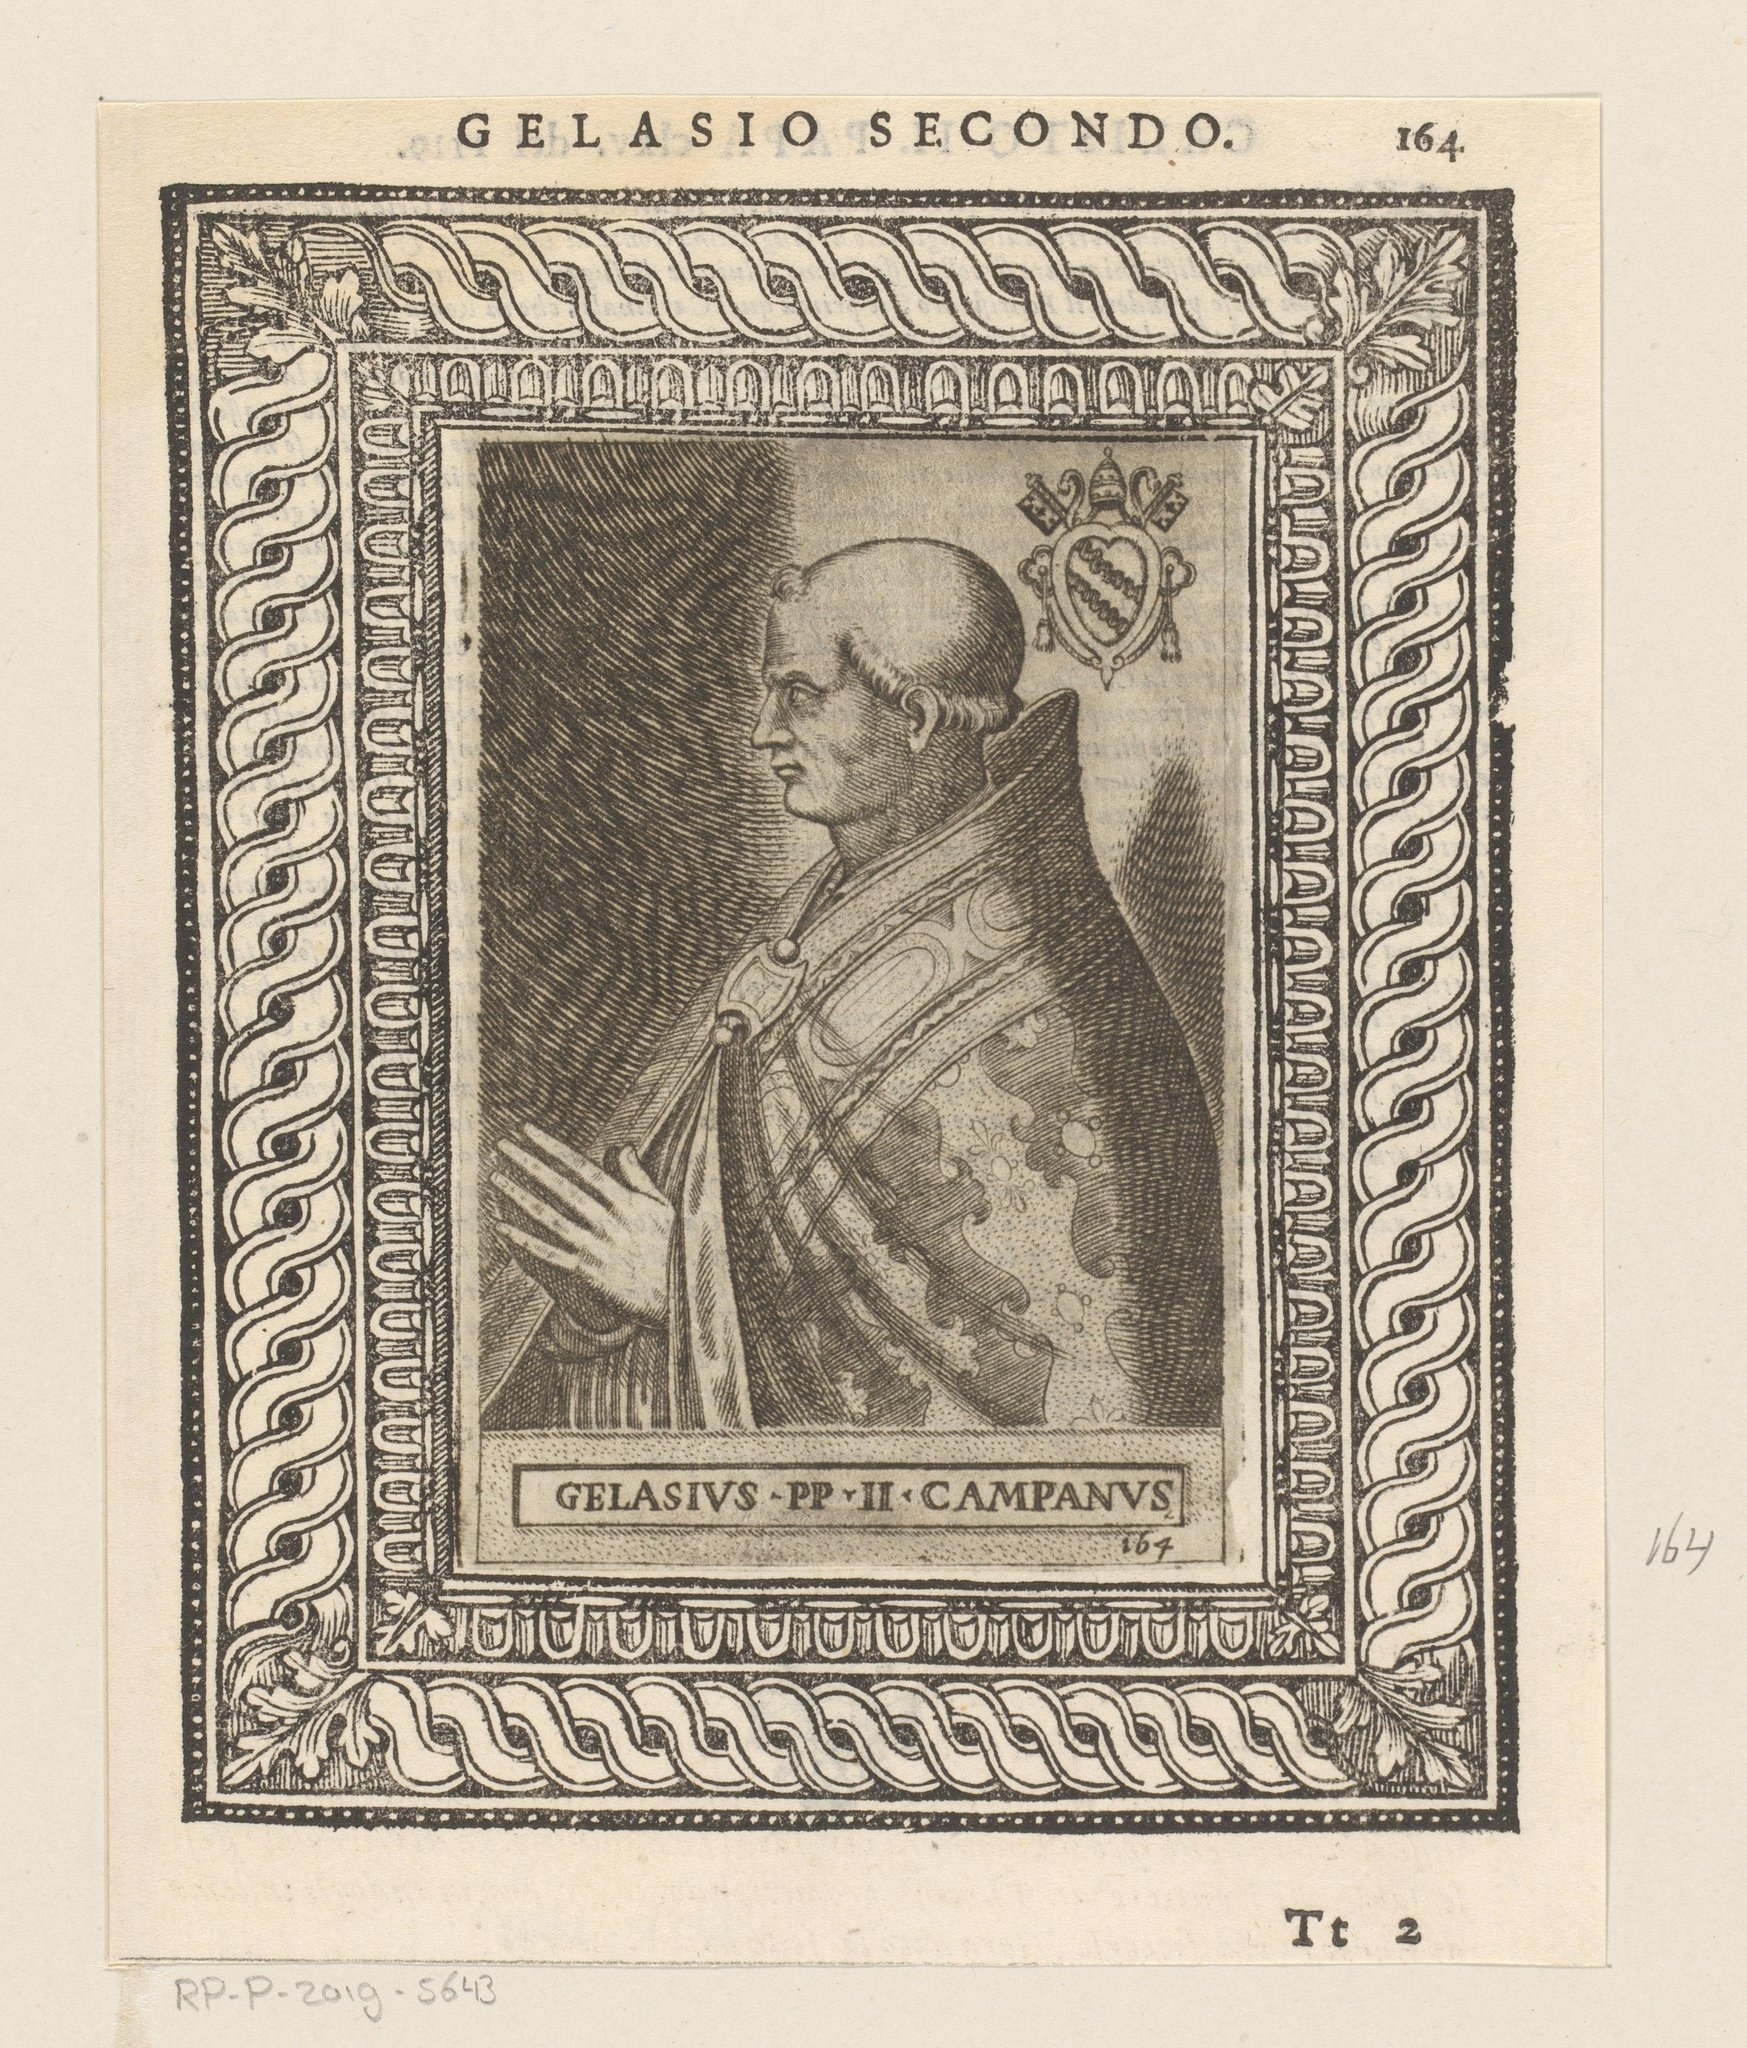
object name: book illustration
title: Gelasius PP II Campanus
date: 1587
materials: paper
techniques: engraving, letterpress printing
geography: rome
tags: historical persons, pope, armorial bearing, heraldry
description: Prent uit: Ciccarelli, Antonio. Le vite de Pontefici di Antonio Ciccarelli (...). Rome: Domenico Basa, 1587. Prent voor het eerst verschenen in: Cavalieri, Giovanni Battista de'. Pontificum romanorum effigies (...). Rome: Domenico Basa en Francesco Zanetti, 1580. Prent ook gebruikt in latere publicaties.